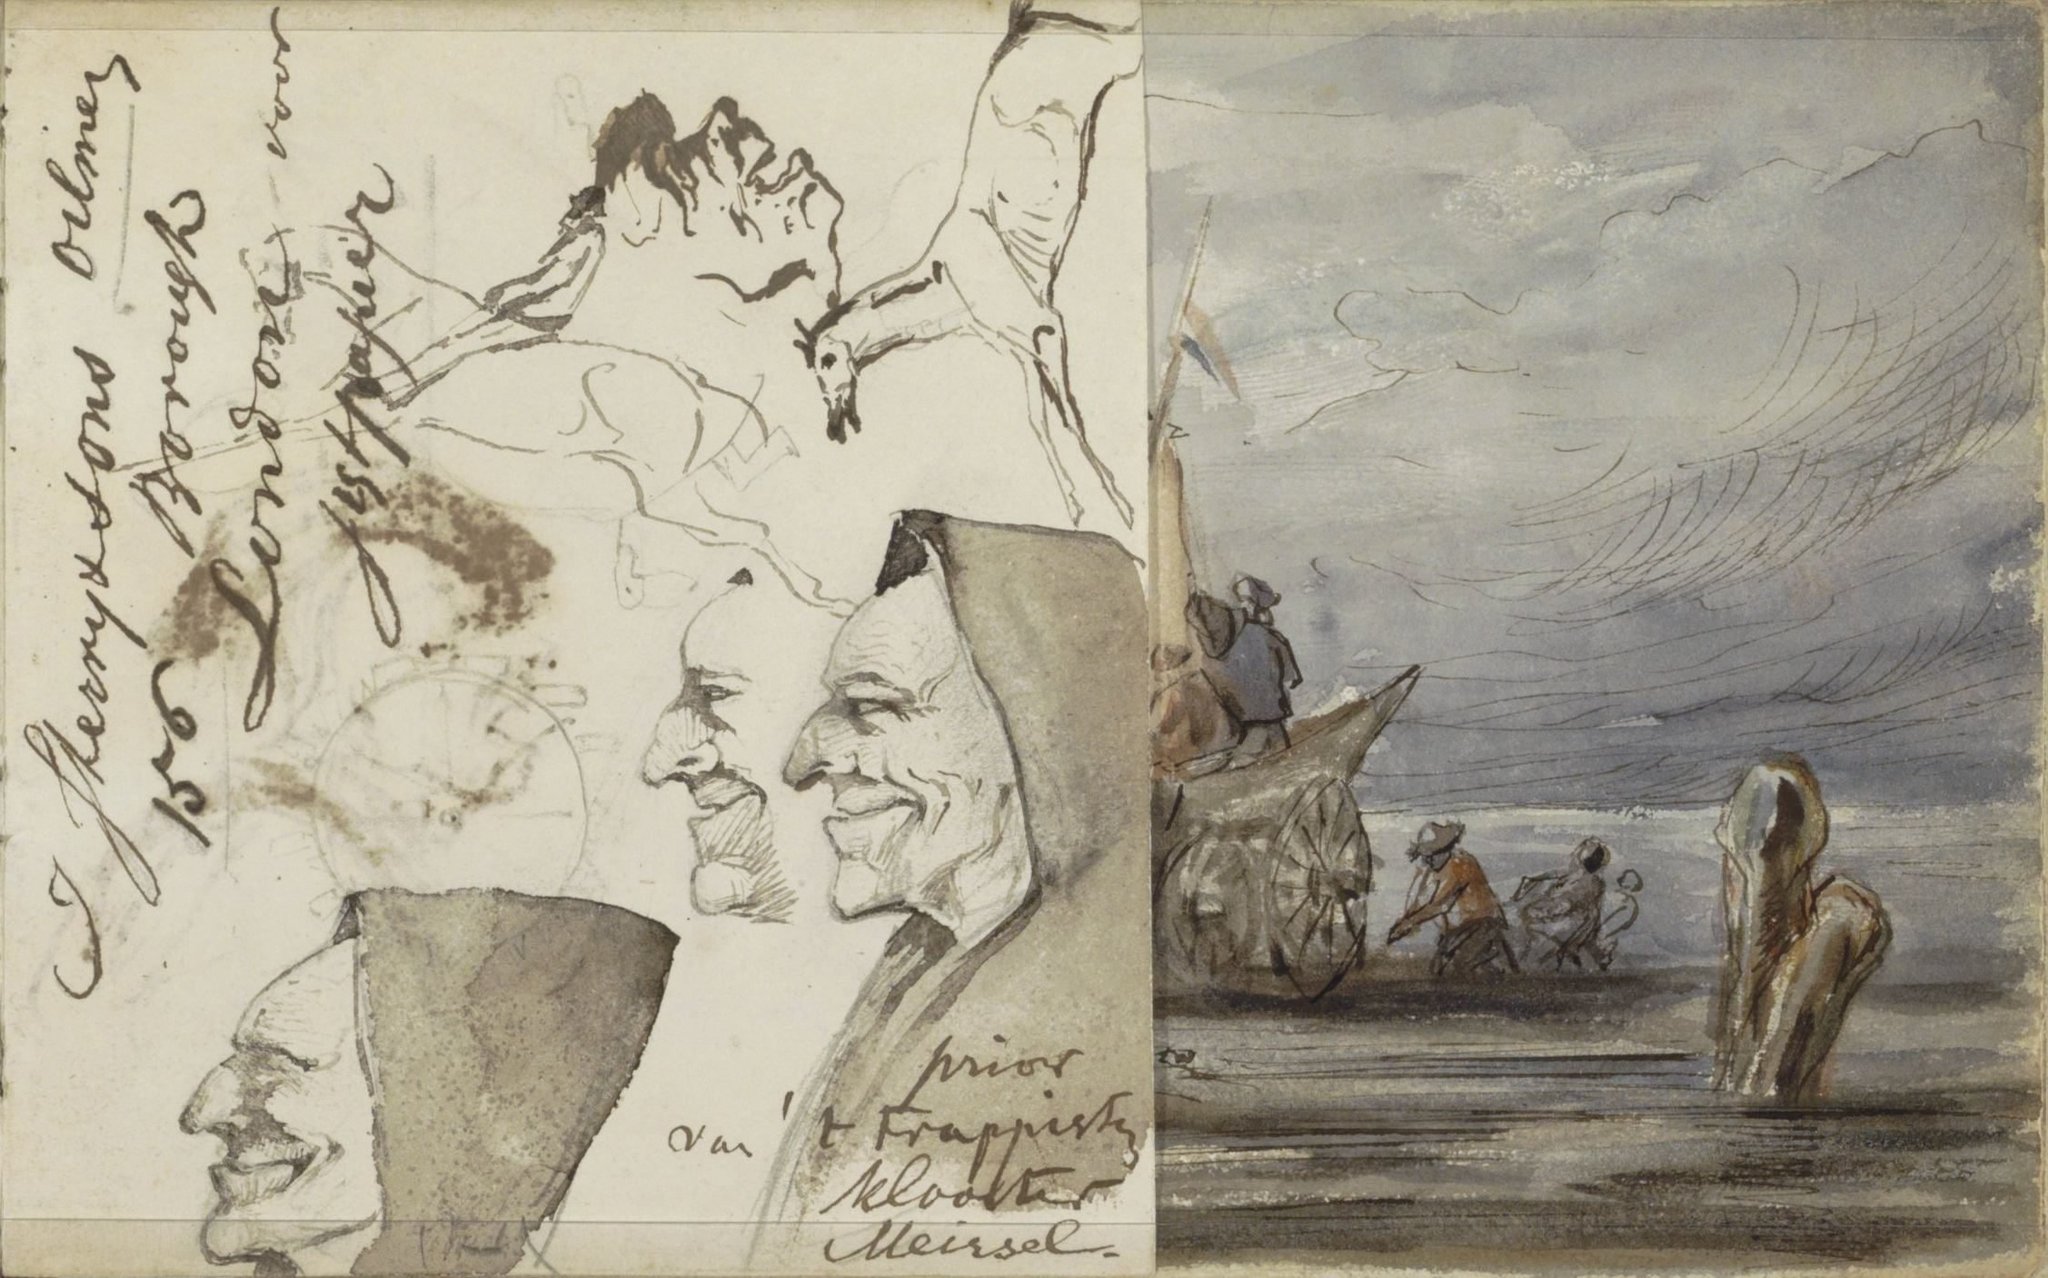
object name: sketchbook leaf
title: Prior van het Trappistenklooster Meirsel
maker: johannes tavenraat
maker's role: draughtsman, painter, print maker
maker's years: 1809-1881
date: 1839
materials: paper, pencil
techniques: pen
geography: ginneken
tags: riding a horse, ass, or mule; rider, horseman, head (human), monk(s), friar(s), horse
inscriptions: annotation: ‘J Sherry & Sons [...]/ 156 Borough/ London voor/ [...]papier/ prior/ van 't Trappisten/ klooster/ Meirsel.’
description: Tevens studies van een ruiter en een paard. Blad 1 recto uit een schetsboek met 37 bladen